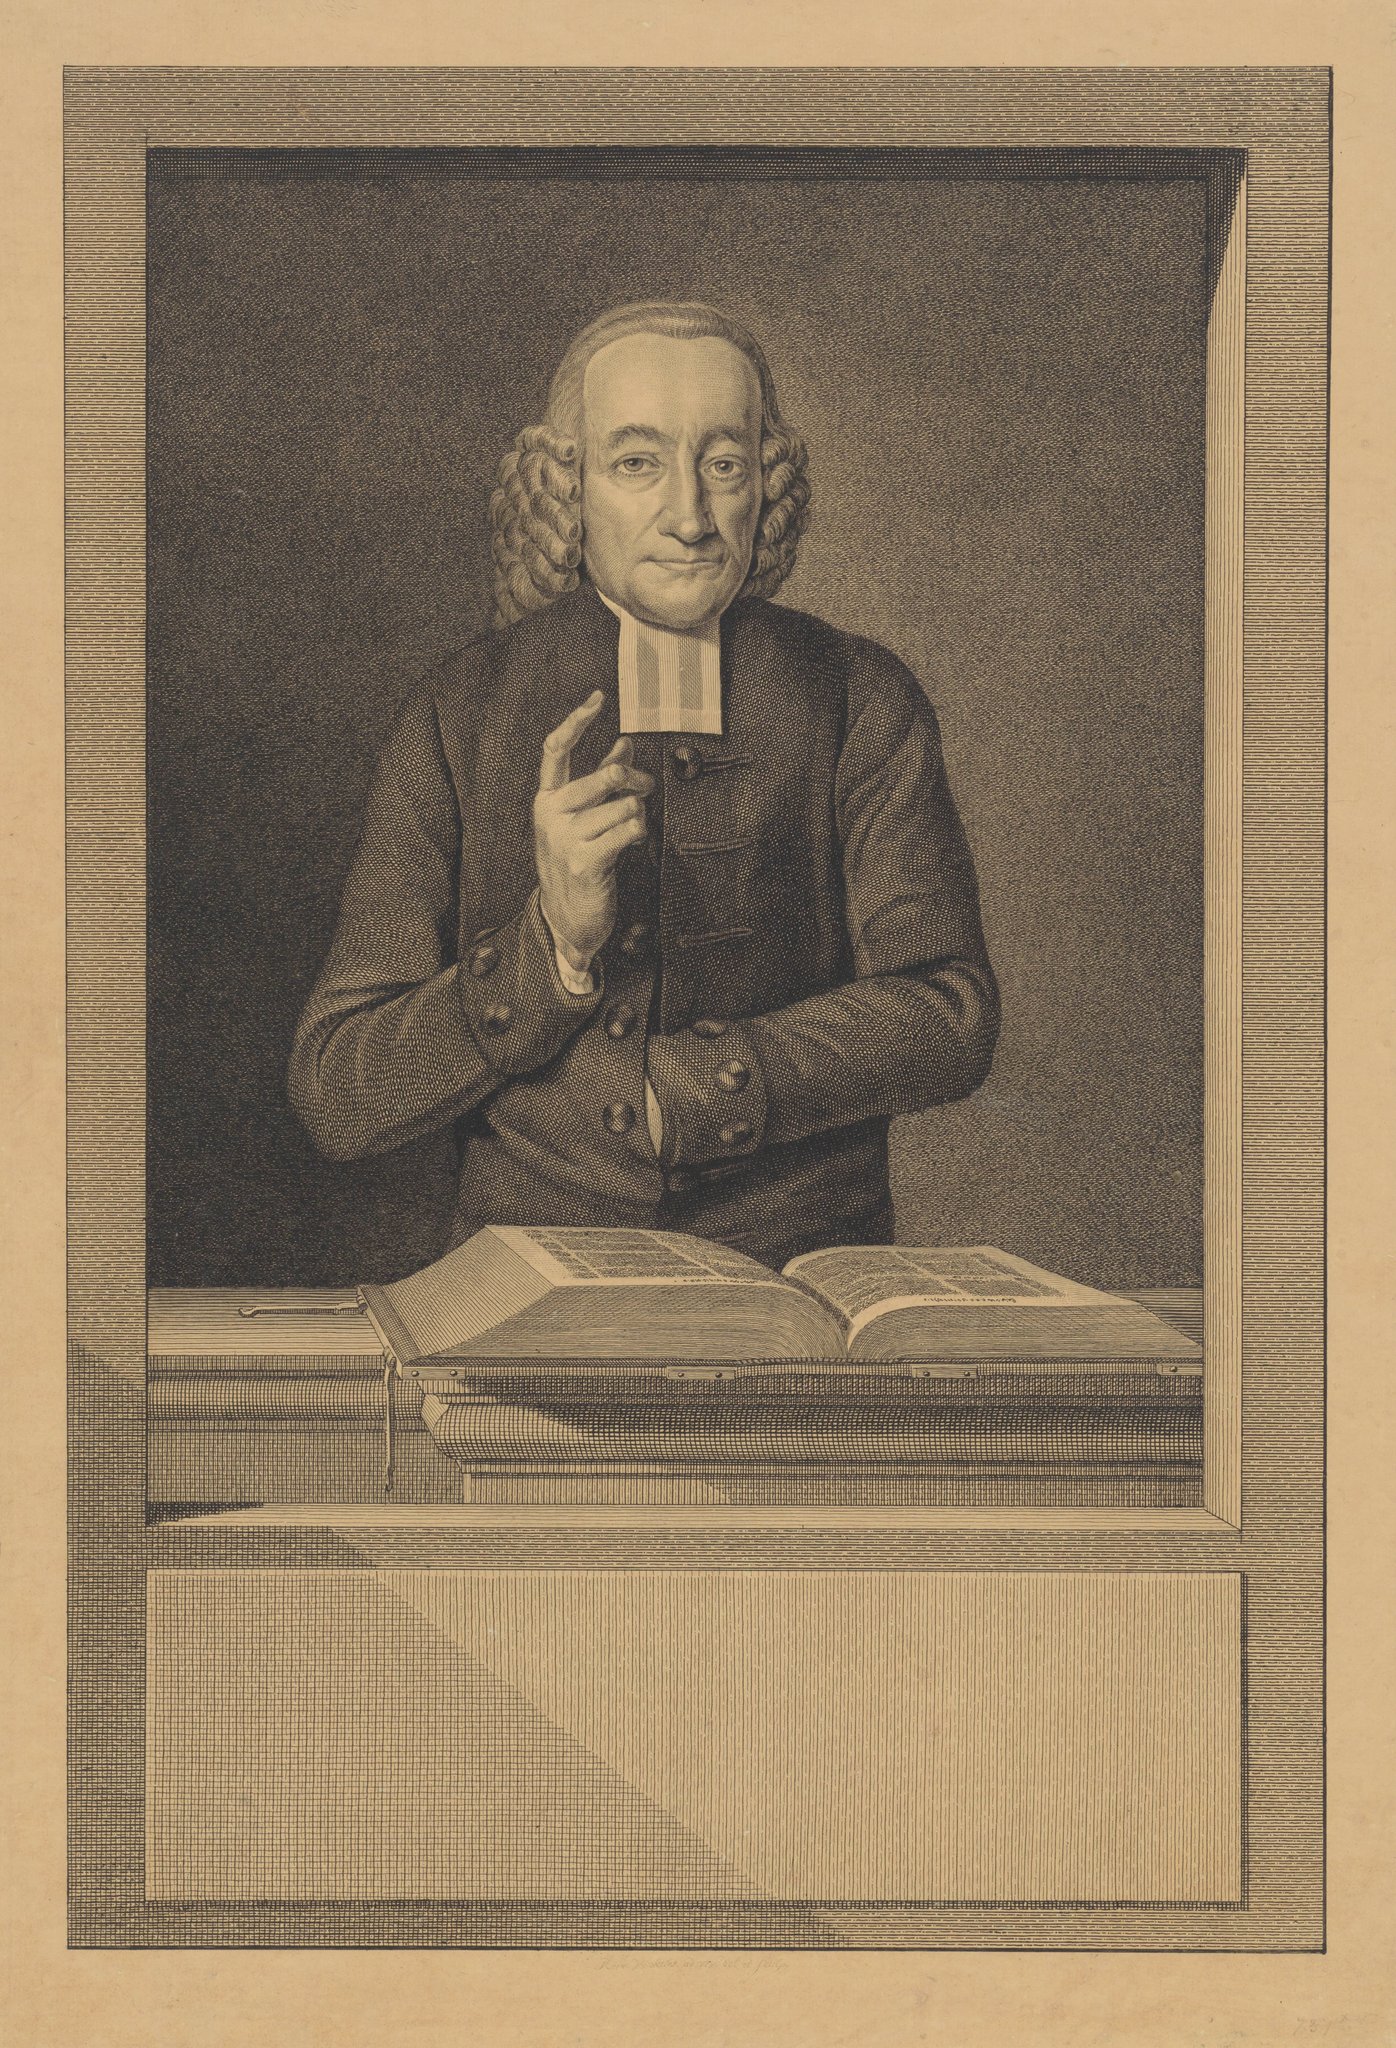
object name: print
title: Portret van Petrus Broes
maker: reinier vinkeles (i)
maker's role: draughtsman, print maker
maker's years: 1741-1816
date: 1792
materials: paper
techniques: engraving, etching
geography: amsterdam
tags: the bible as a book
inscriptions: collector's mark: Lugt 2228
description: Portret van Petrus Broes, predikant te Amsterdam, predikend met voor zich een opengeslagen bijbel.